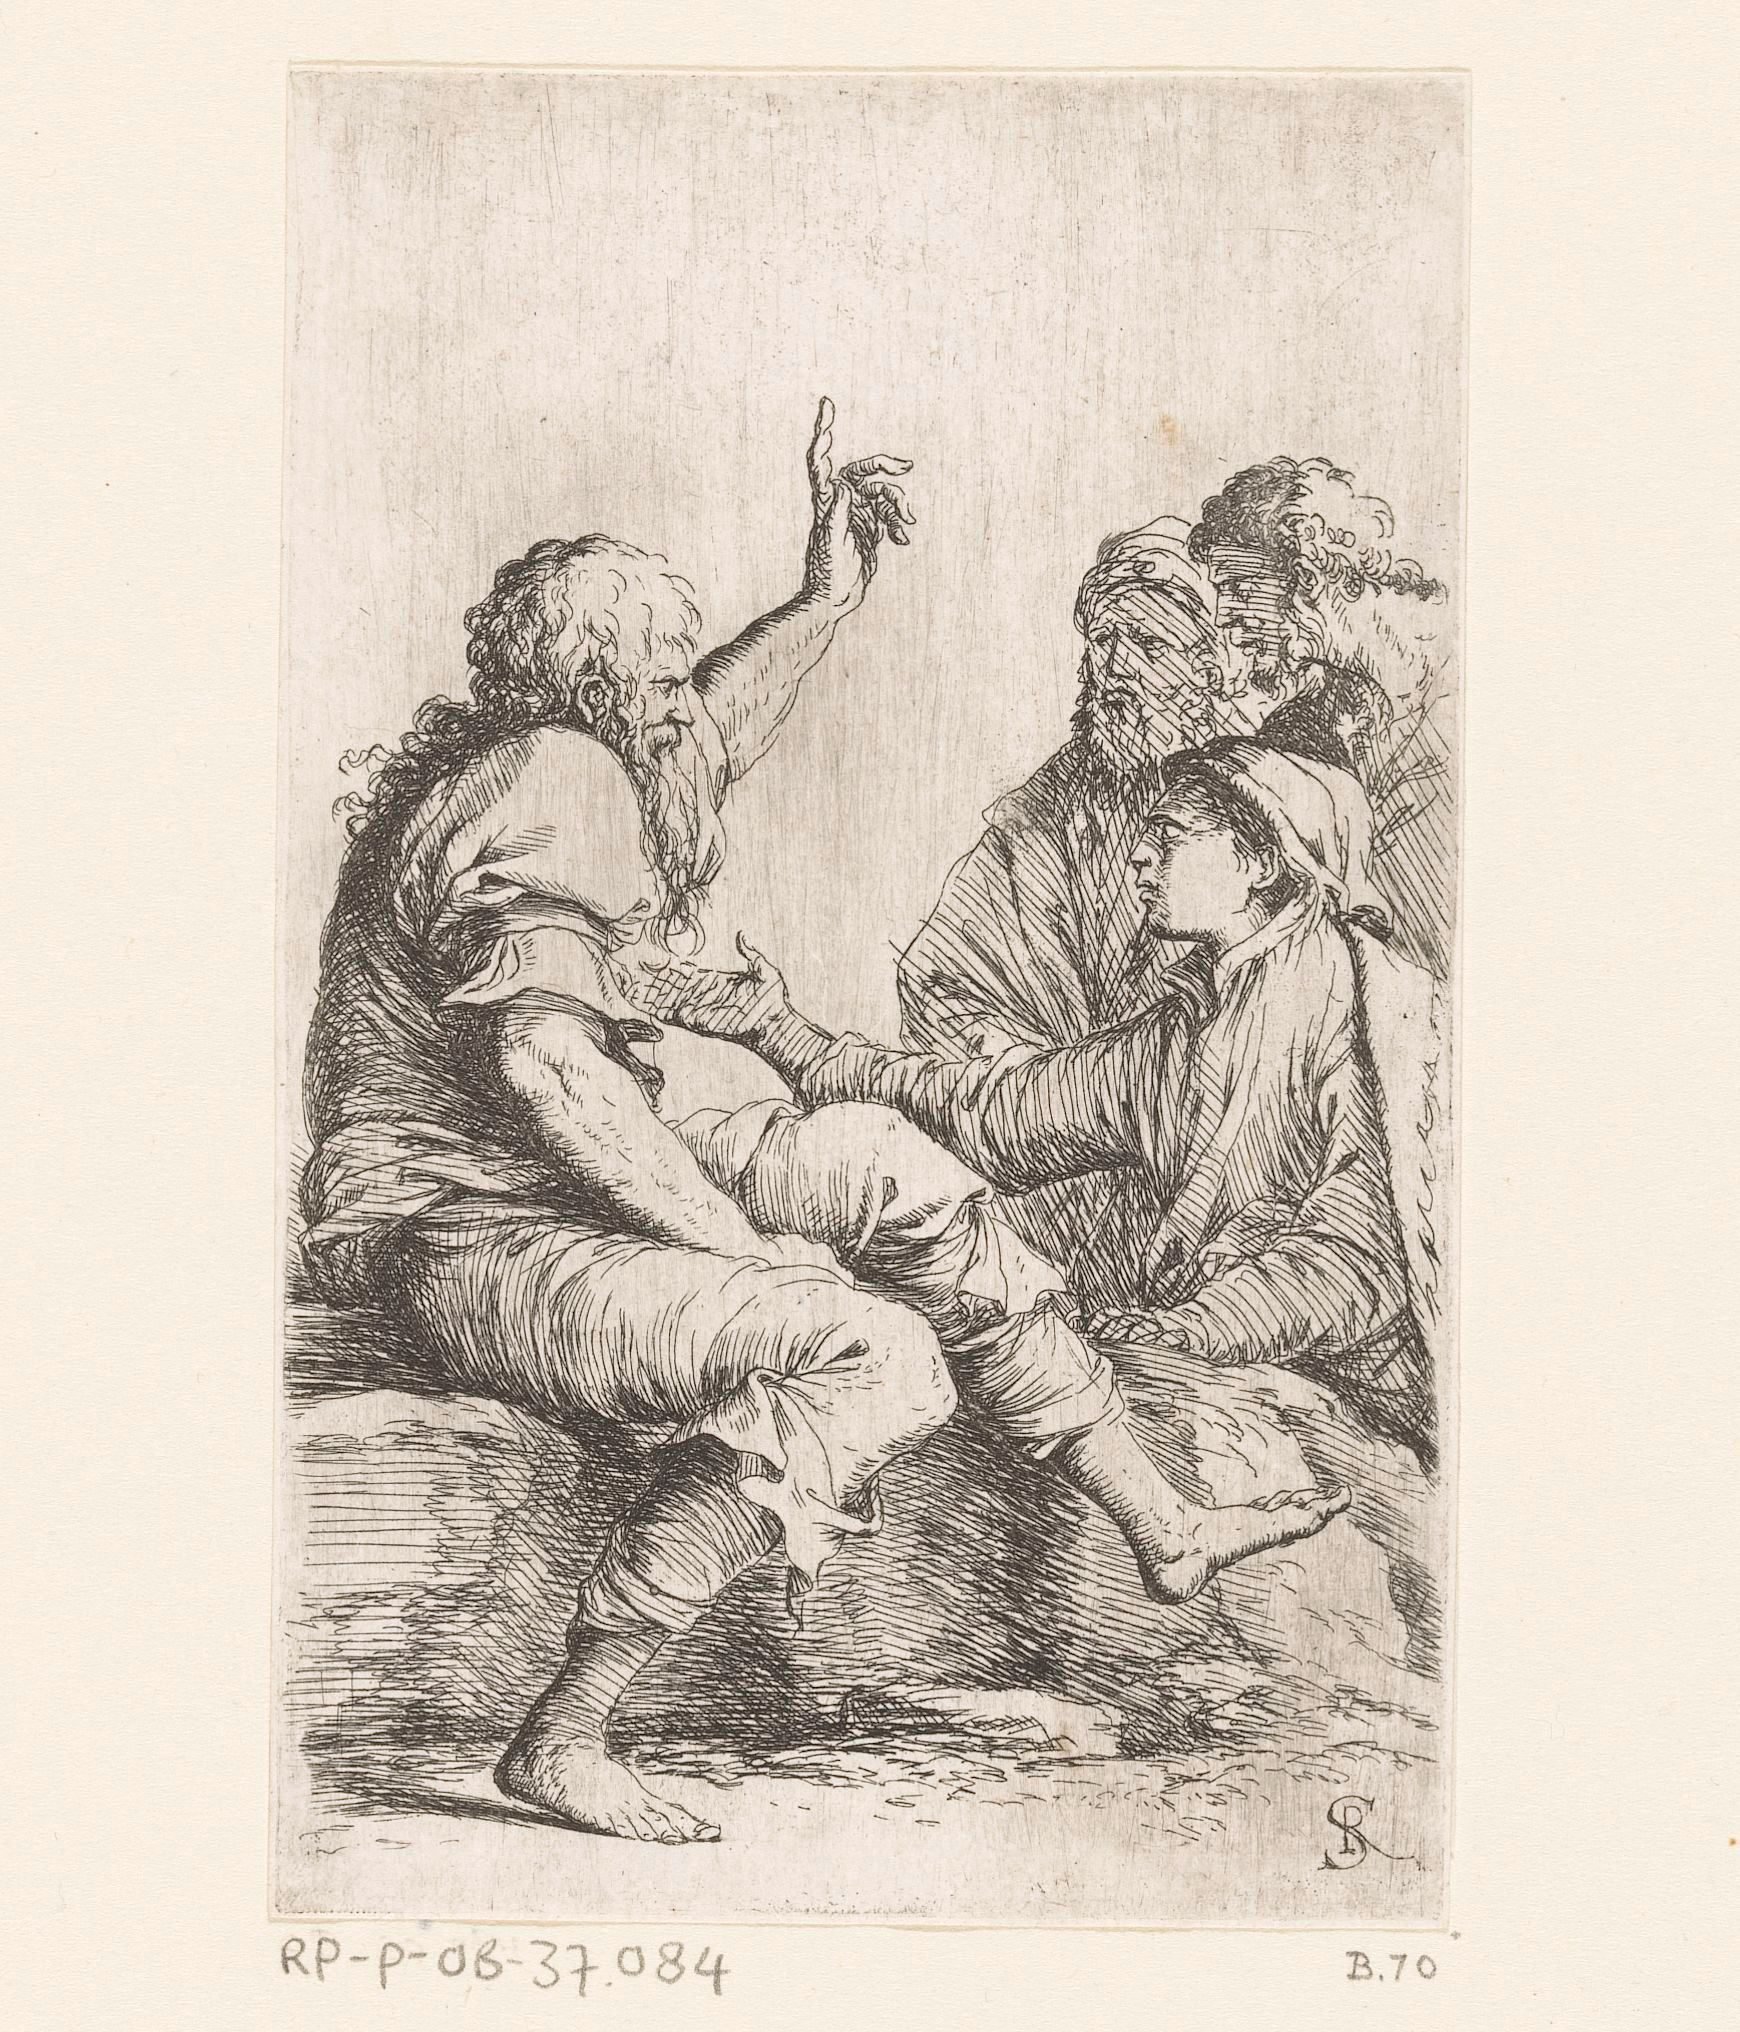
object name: print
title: Vier mannen in conversatie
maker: salvator rosa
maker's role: draughtsman, painter, print maker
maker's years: 1615-1673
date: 1656-1657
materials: paper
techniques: drypoint, etching, intaglio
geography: italy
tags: old man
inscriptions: collector's mark: Lugt 240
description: Deze prent maakt deel uit van de serie 'Figurine', bestaande uit een titelprent en 80 prenten van klein formaat met voorstellingen van mannelijke en vrouwelijke figuren. Rosa produceerde de serie waarschijnlijk gedurende de jaren 1656 en 1657.